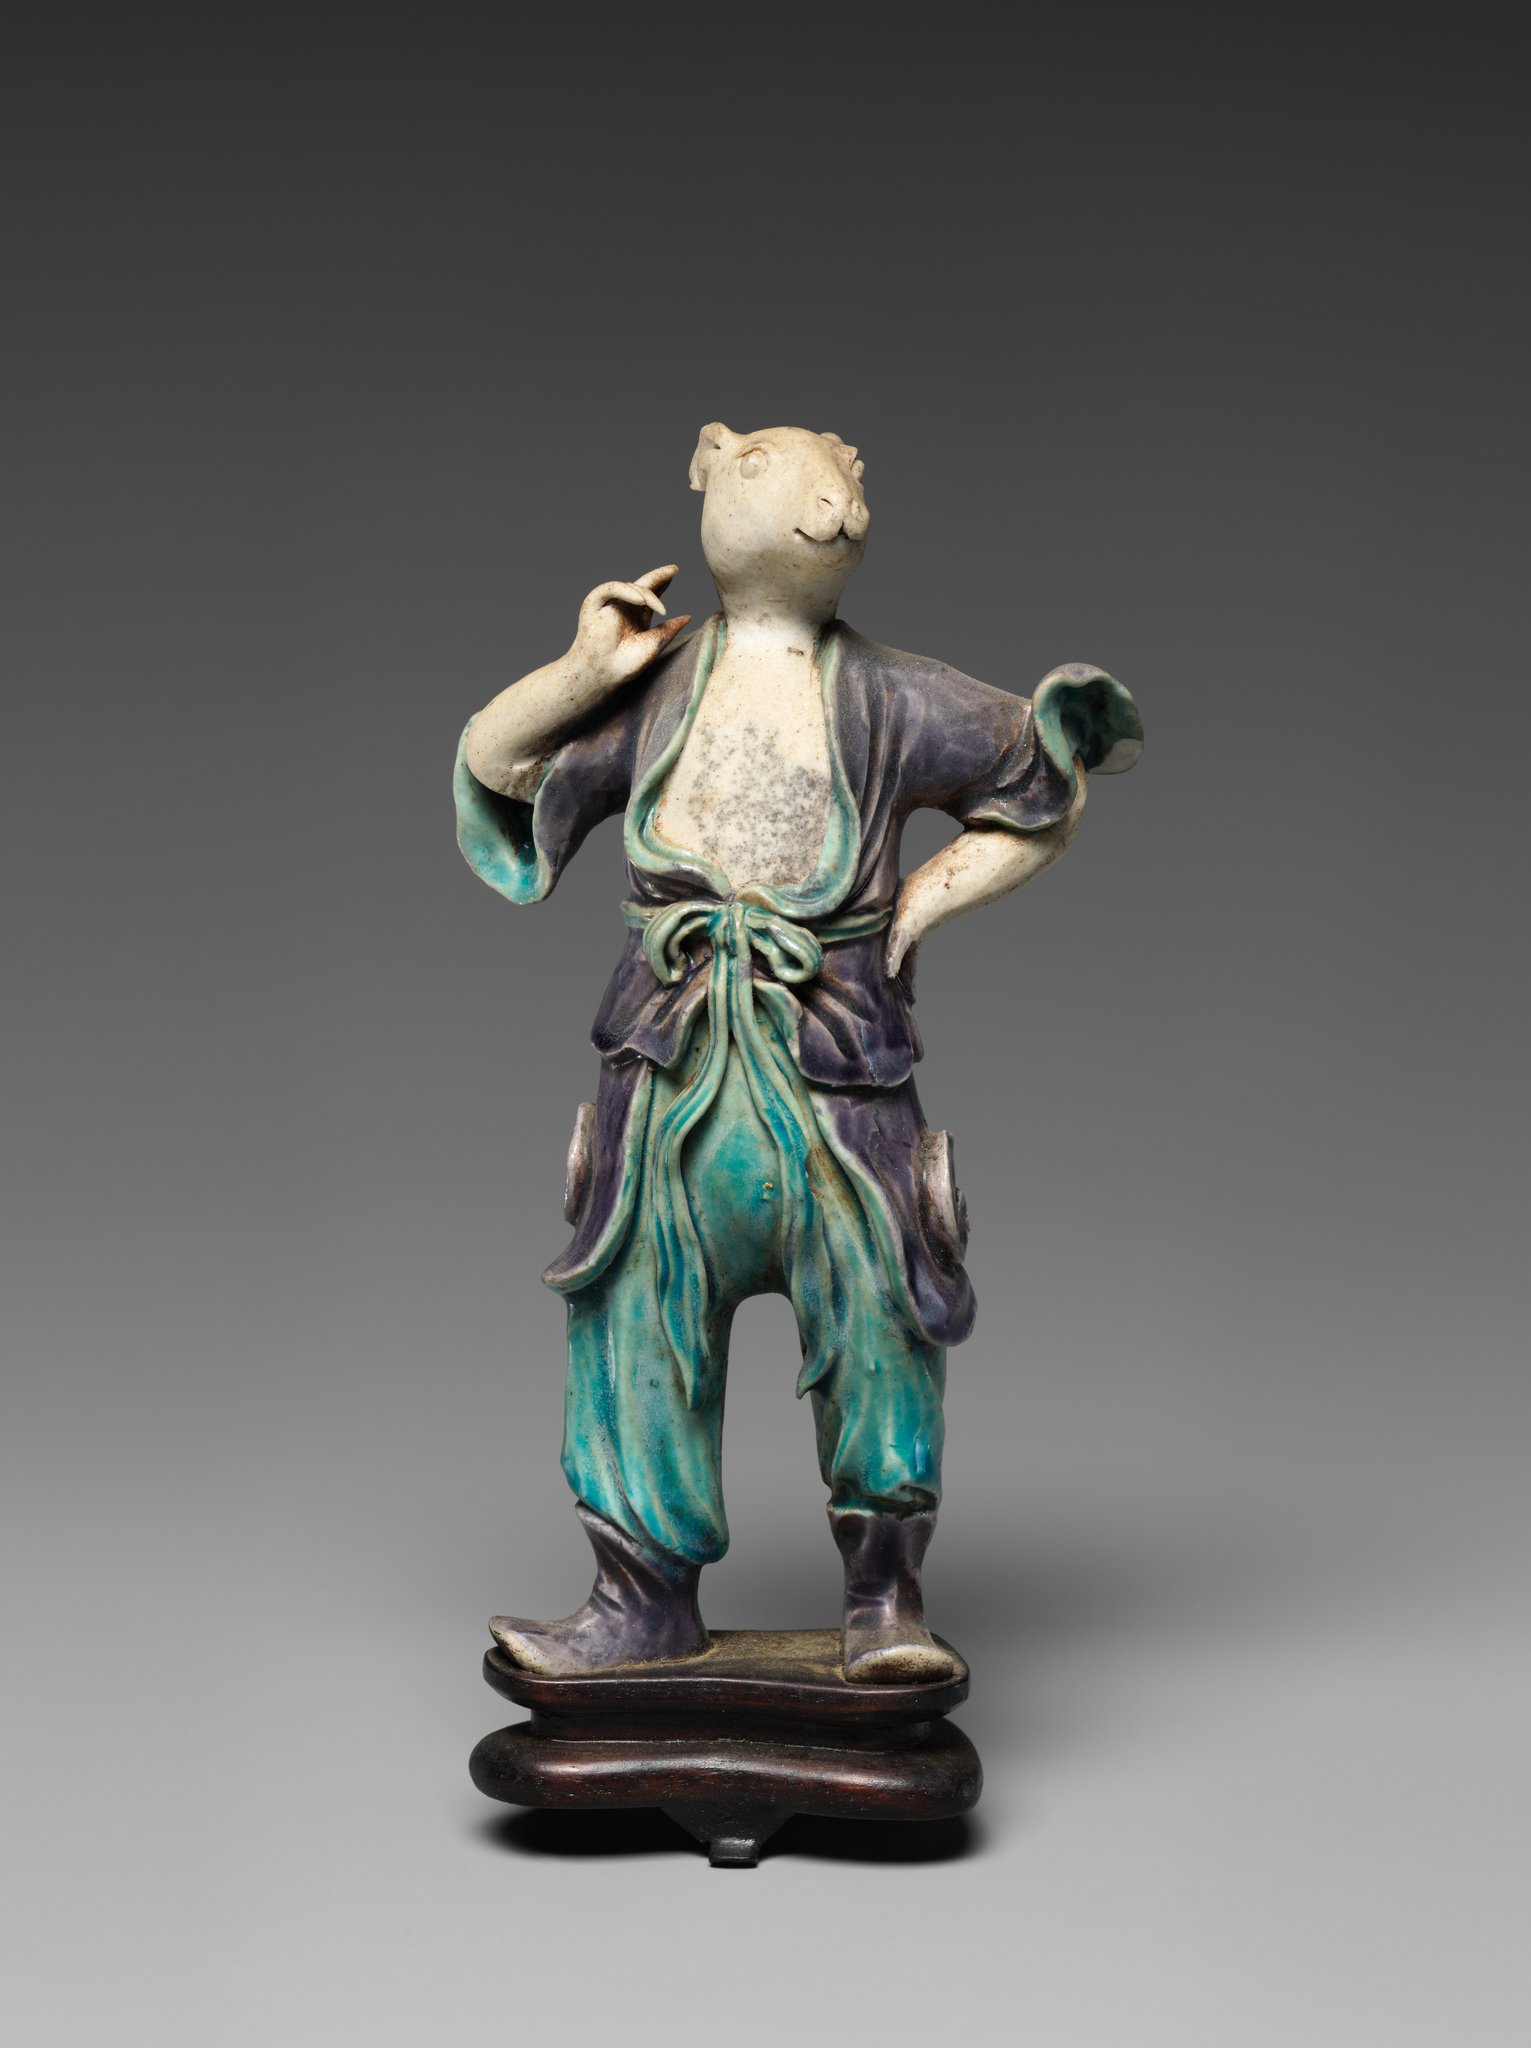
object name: figure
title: Zodiac figure: rabbit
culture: chinese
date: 1662-1722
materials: biscuit, glaze, porcelain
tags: rabbits,zodiac